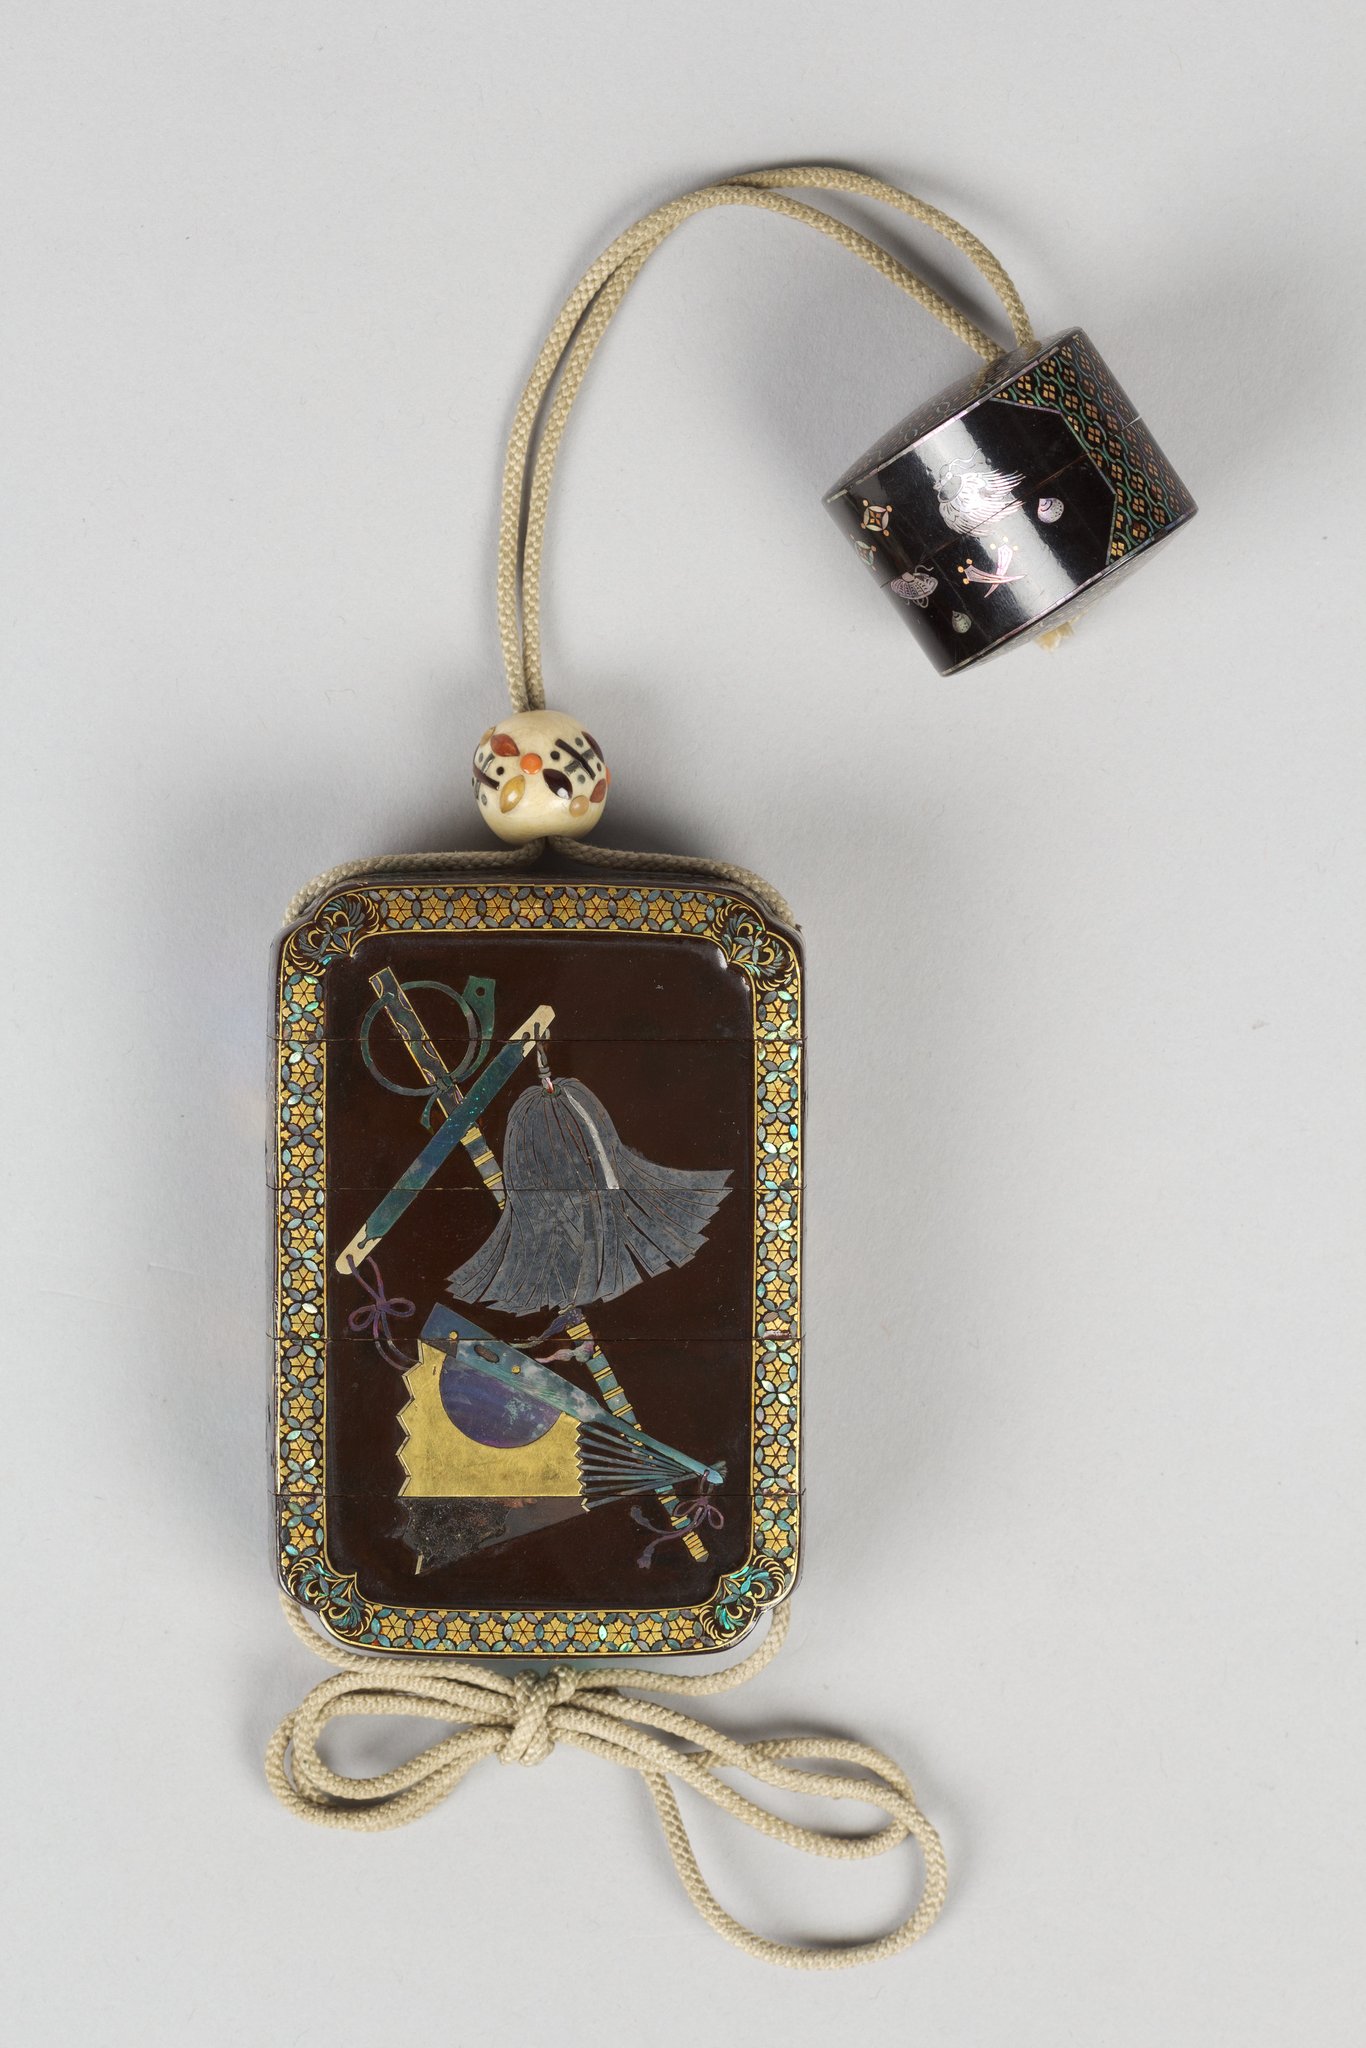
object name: inrō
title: Case (Inrō) with Design of Commander's Baton and Other Military Objects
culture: japanese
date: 1801-1900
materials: gold foil, lacquer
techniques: fundame, inlay, roiro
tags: fans,military equipment